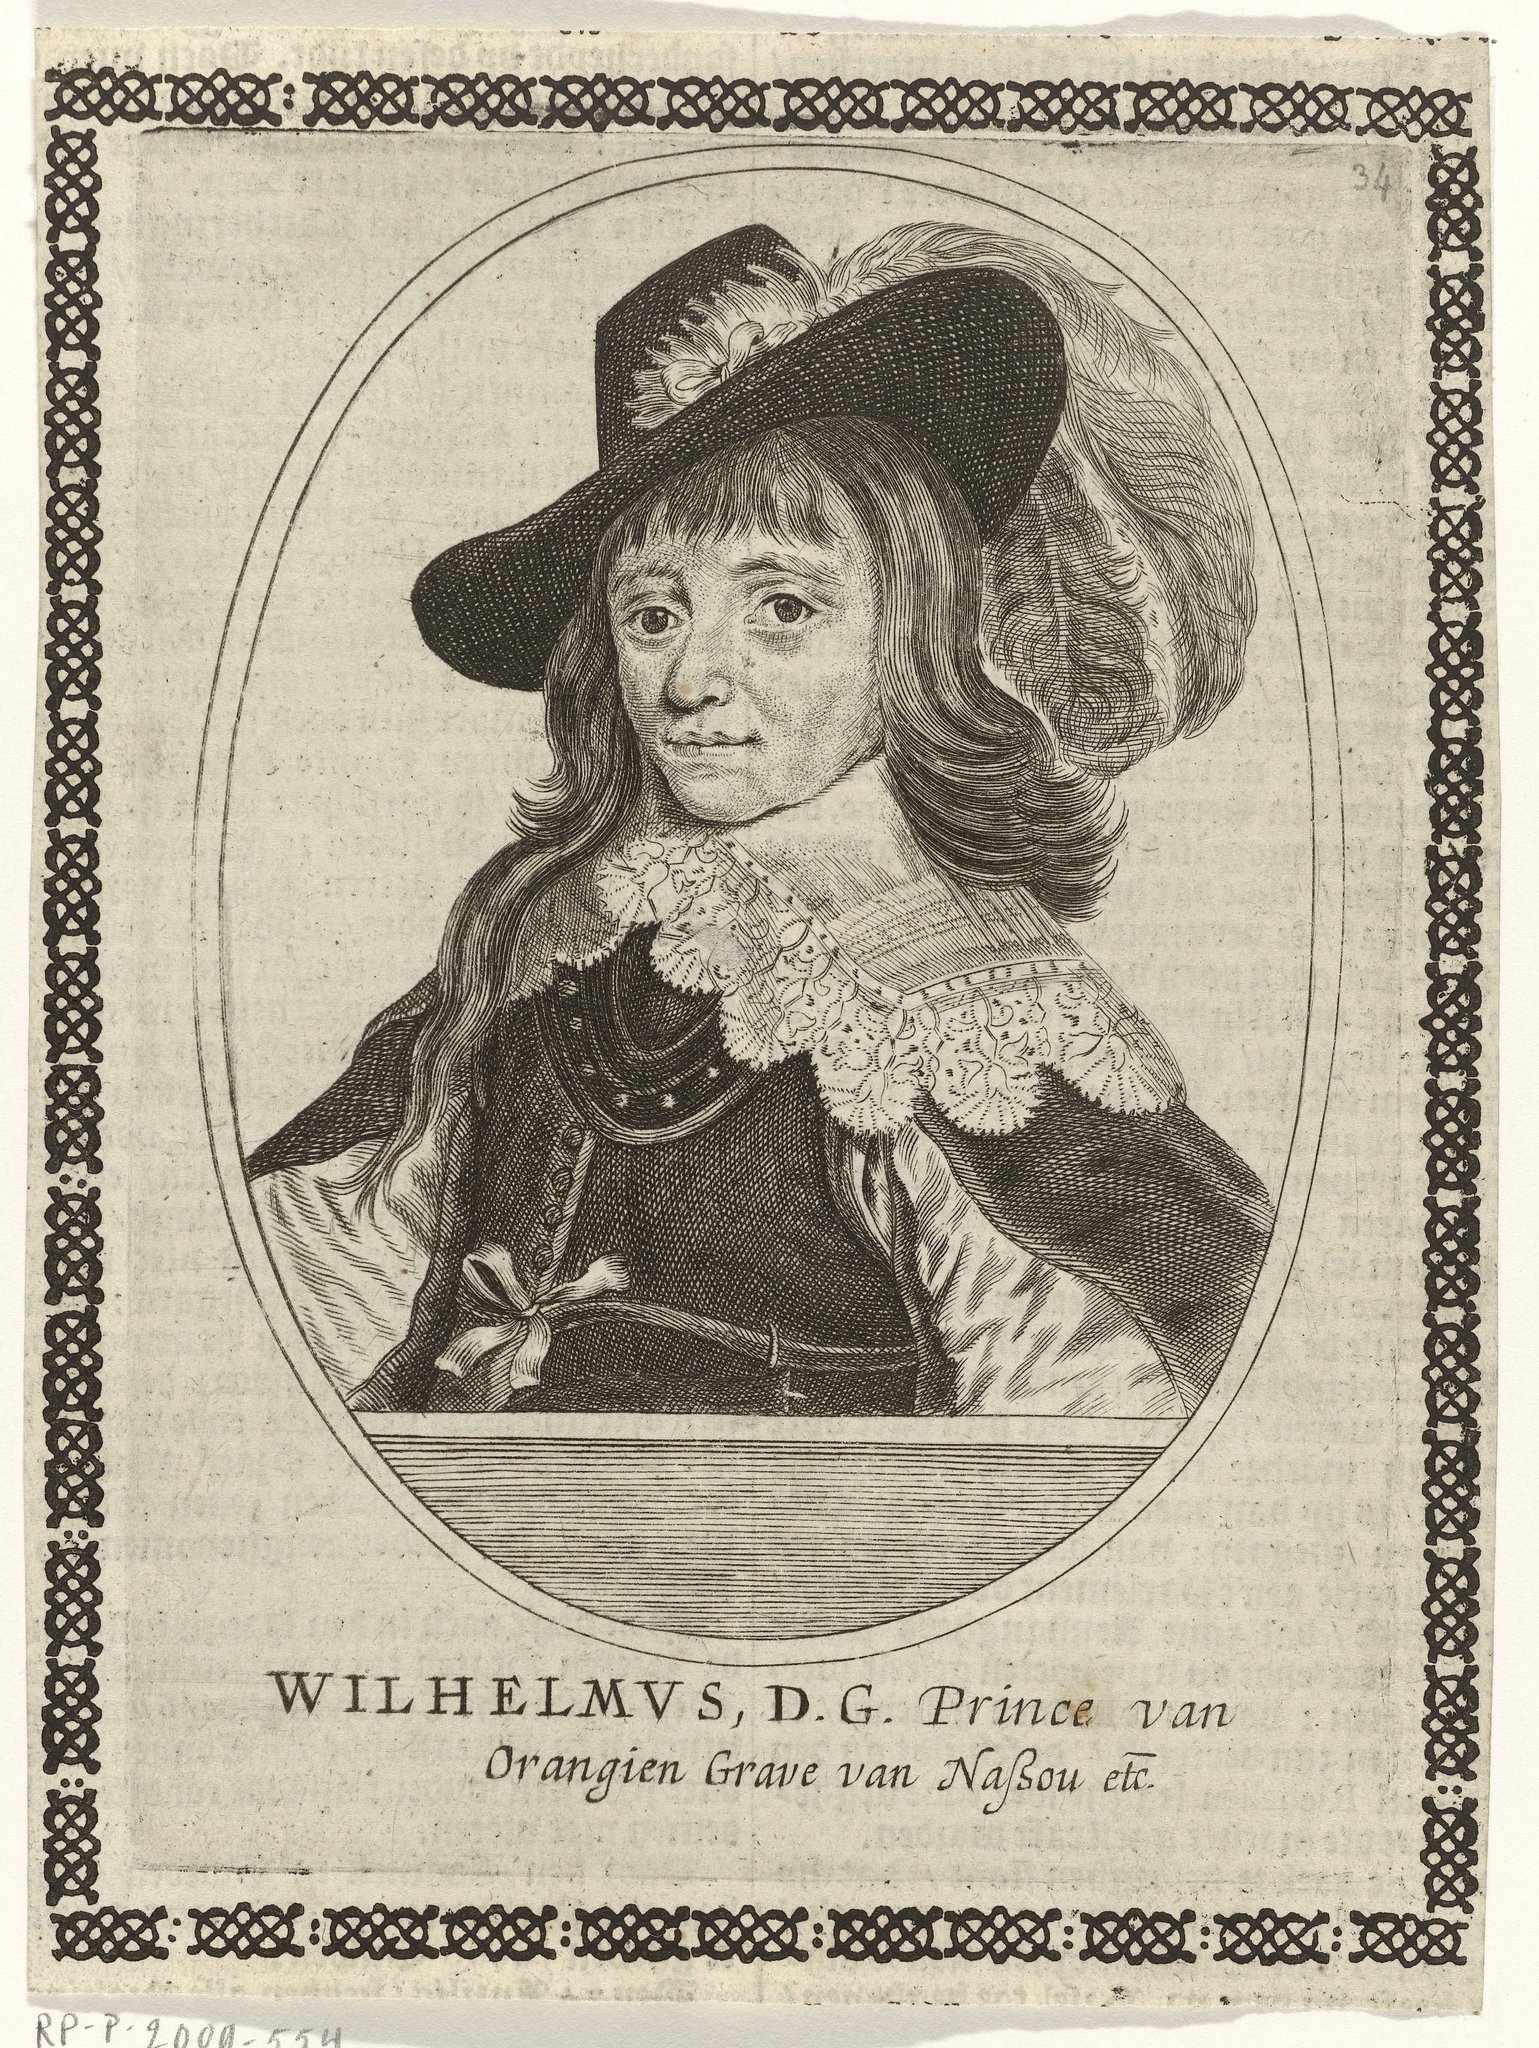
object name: print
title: Portret van Willem II, prins van Oranje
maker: Anonymous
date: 1650-1749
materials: paper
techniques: engraving, etching, letterpress printing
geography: low countries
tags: william ii (prince of orange)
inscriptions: collector's mark: Lugt 2228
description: Boekillustratie met portret van Willem II, Prins van Oranje Nassau. Geportretteerde in ovaal in kostuum en met hoed naar links. Onder ovaal een Latijns onderschrift. Om de voorstelling heen een geboekdrukte sierrand.